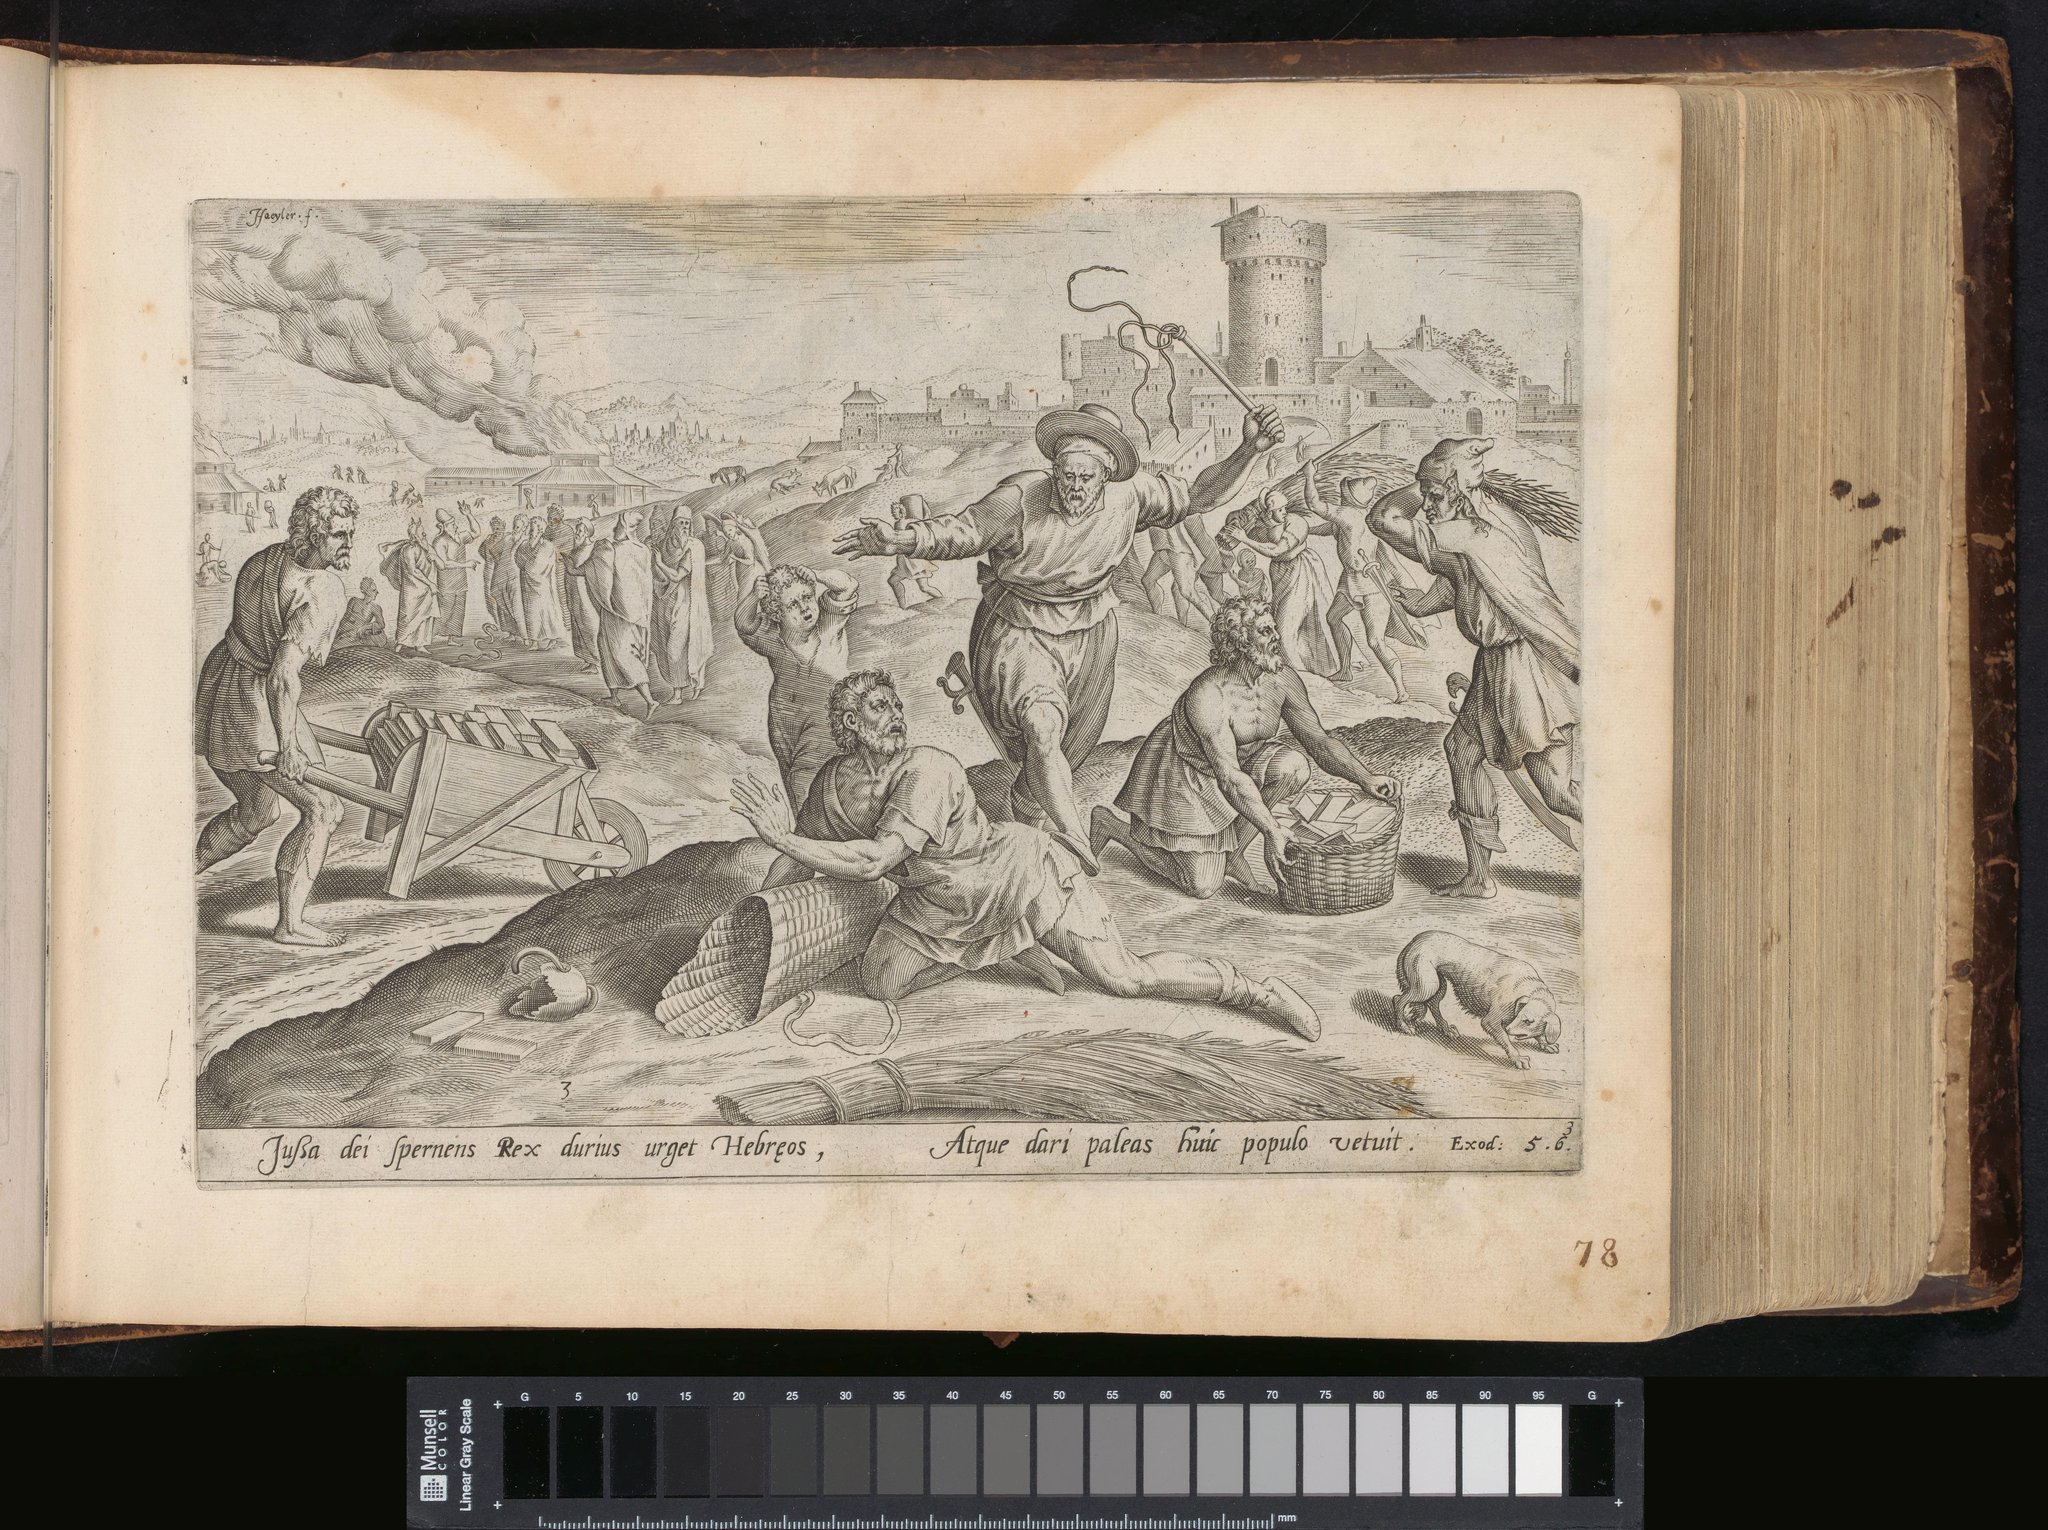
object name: album leaf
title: Den Grooten Figuer-Bibel (...)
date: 1579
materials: paper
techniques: engraving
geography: amsterdam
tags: the israelites complain to moses and aaron (~ pharaoh), pharaoh commands the taskmasters to stop supplying the people with straw for making bricks (+ variant)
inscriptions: number: ‘78’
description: Een Israëlitische arbeider valt op de grond en wordt door een van de Egyptische opzichters van de farao met een zweep geslagen. De Israëlieten verzamelen stro voor het bakken van stenen. Op de achtergrond preken Mozes en Aäron. Onder de voorstelling een verwijzing in het Latijn naar de Bijbeltekst in Ex. 5:6. Deze prent maakt deel uit van een album.